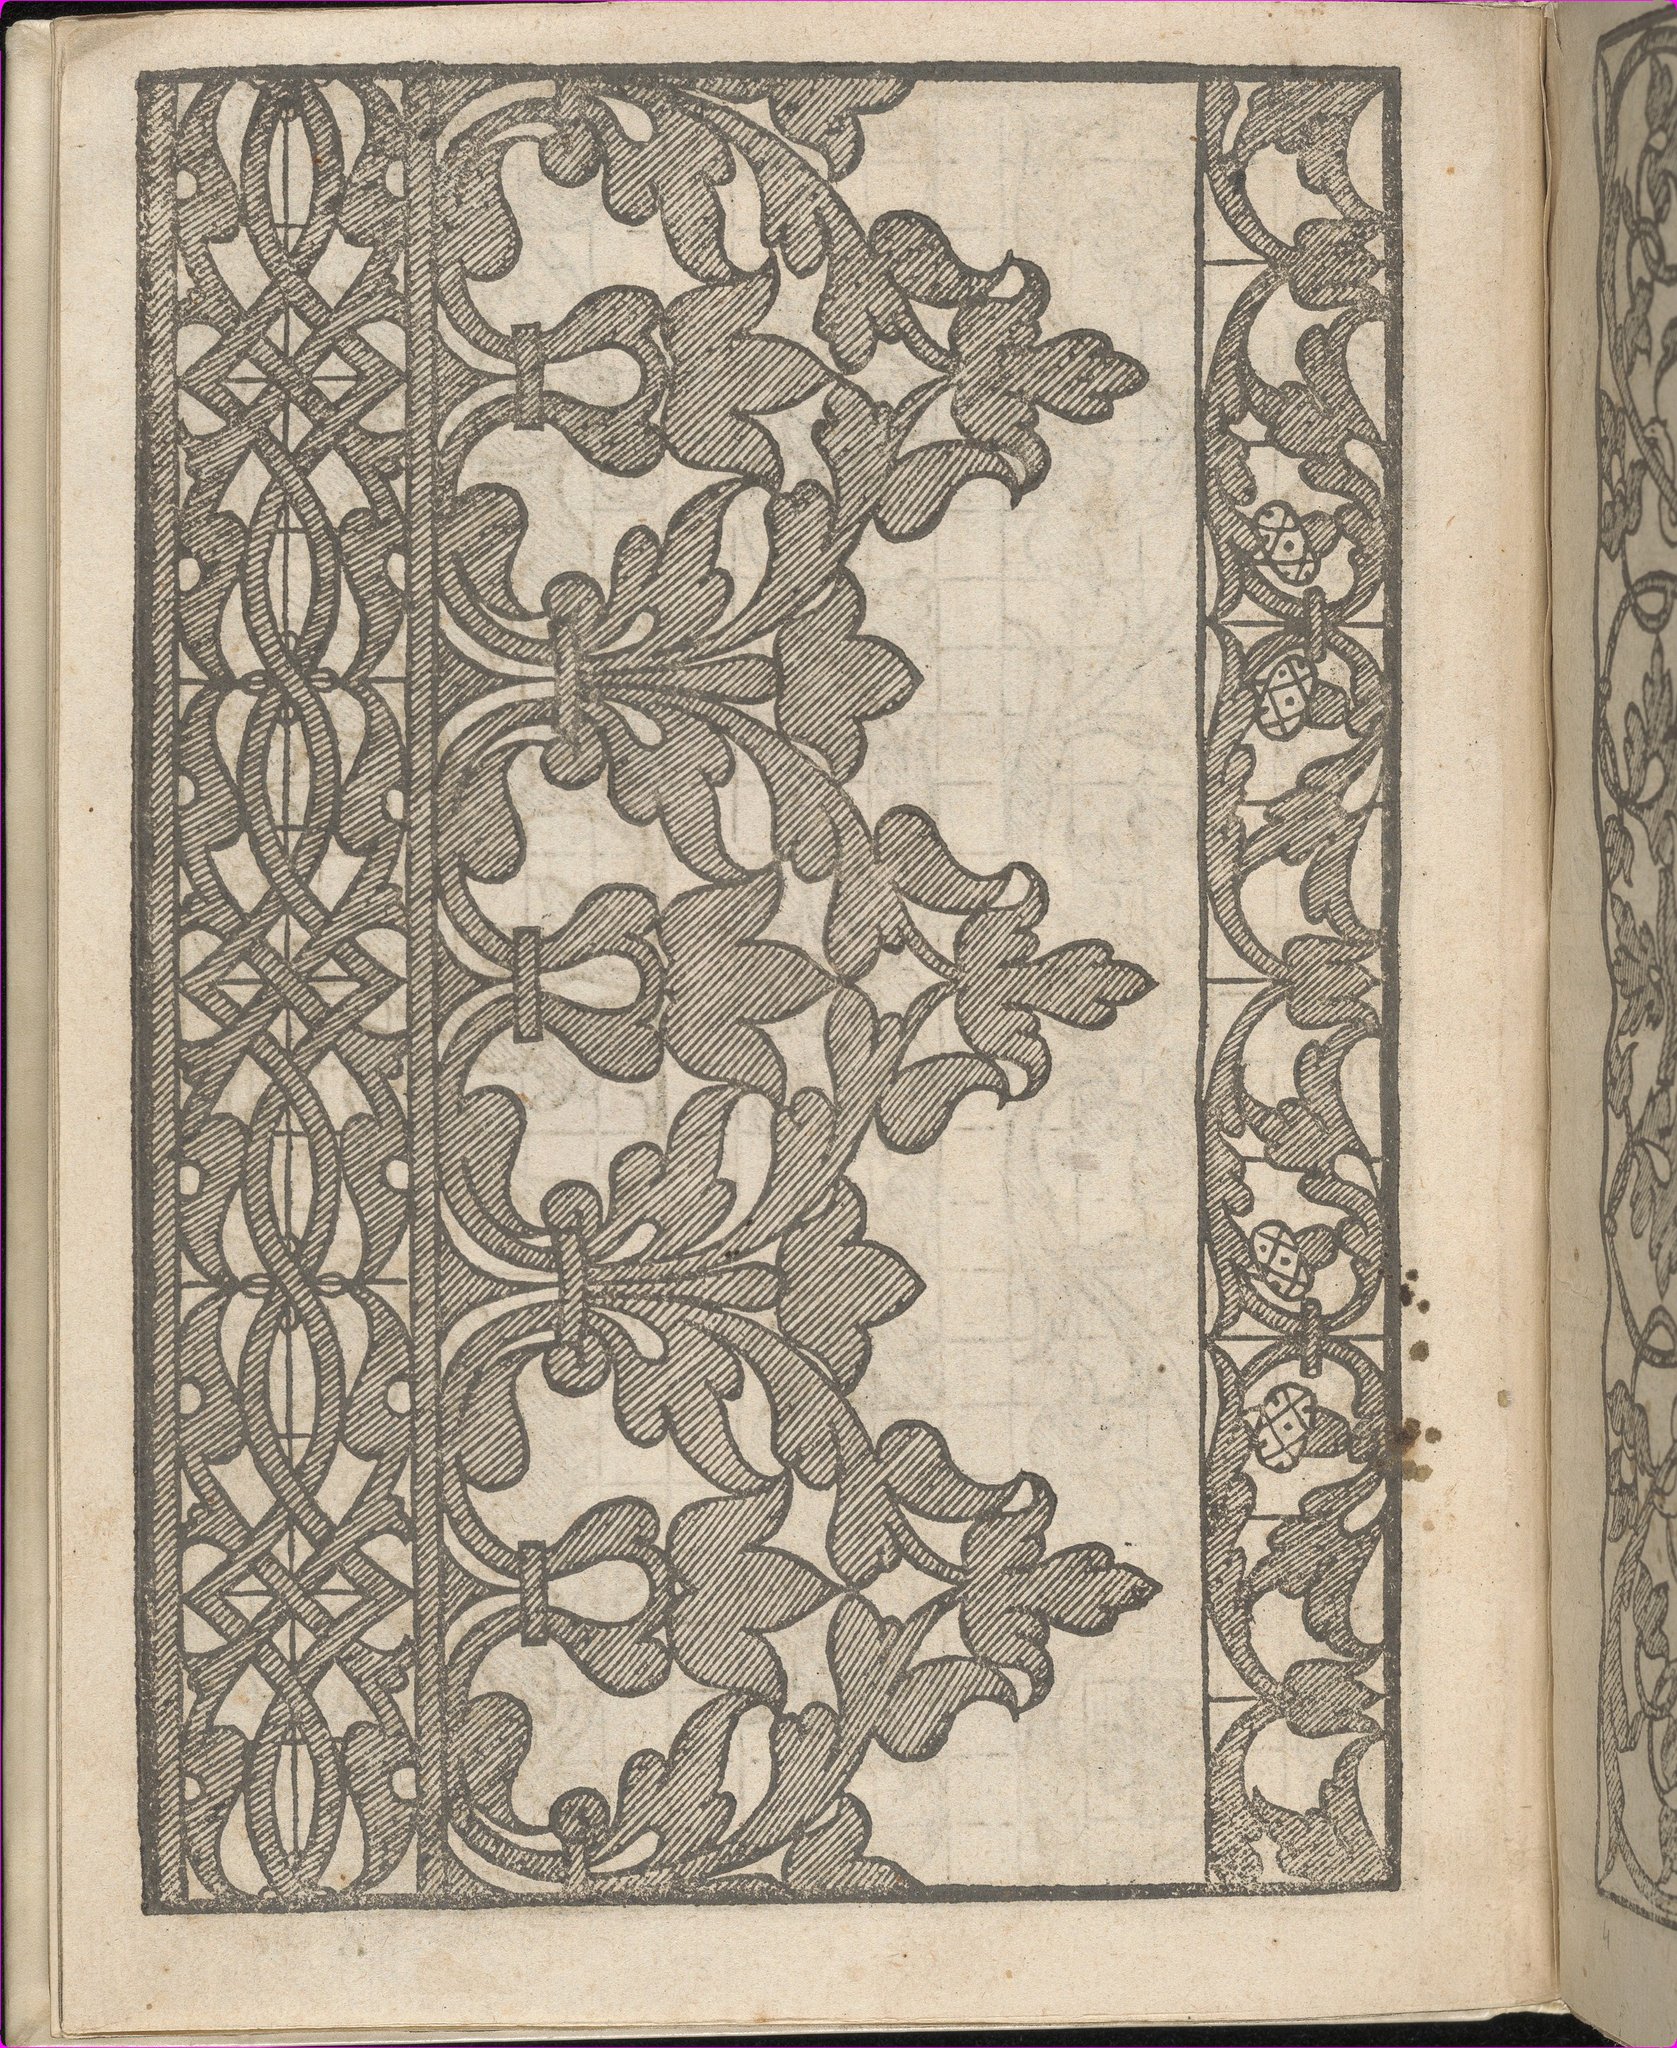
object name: book print ornament architecture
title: Lucidario di Recami, page 4 (recto)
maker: iseppo foresto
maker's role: designer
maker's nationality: italian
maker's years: 1520-1580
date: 1564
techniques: woodcut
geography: italy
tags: ornament